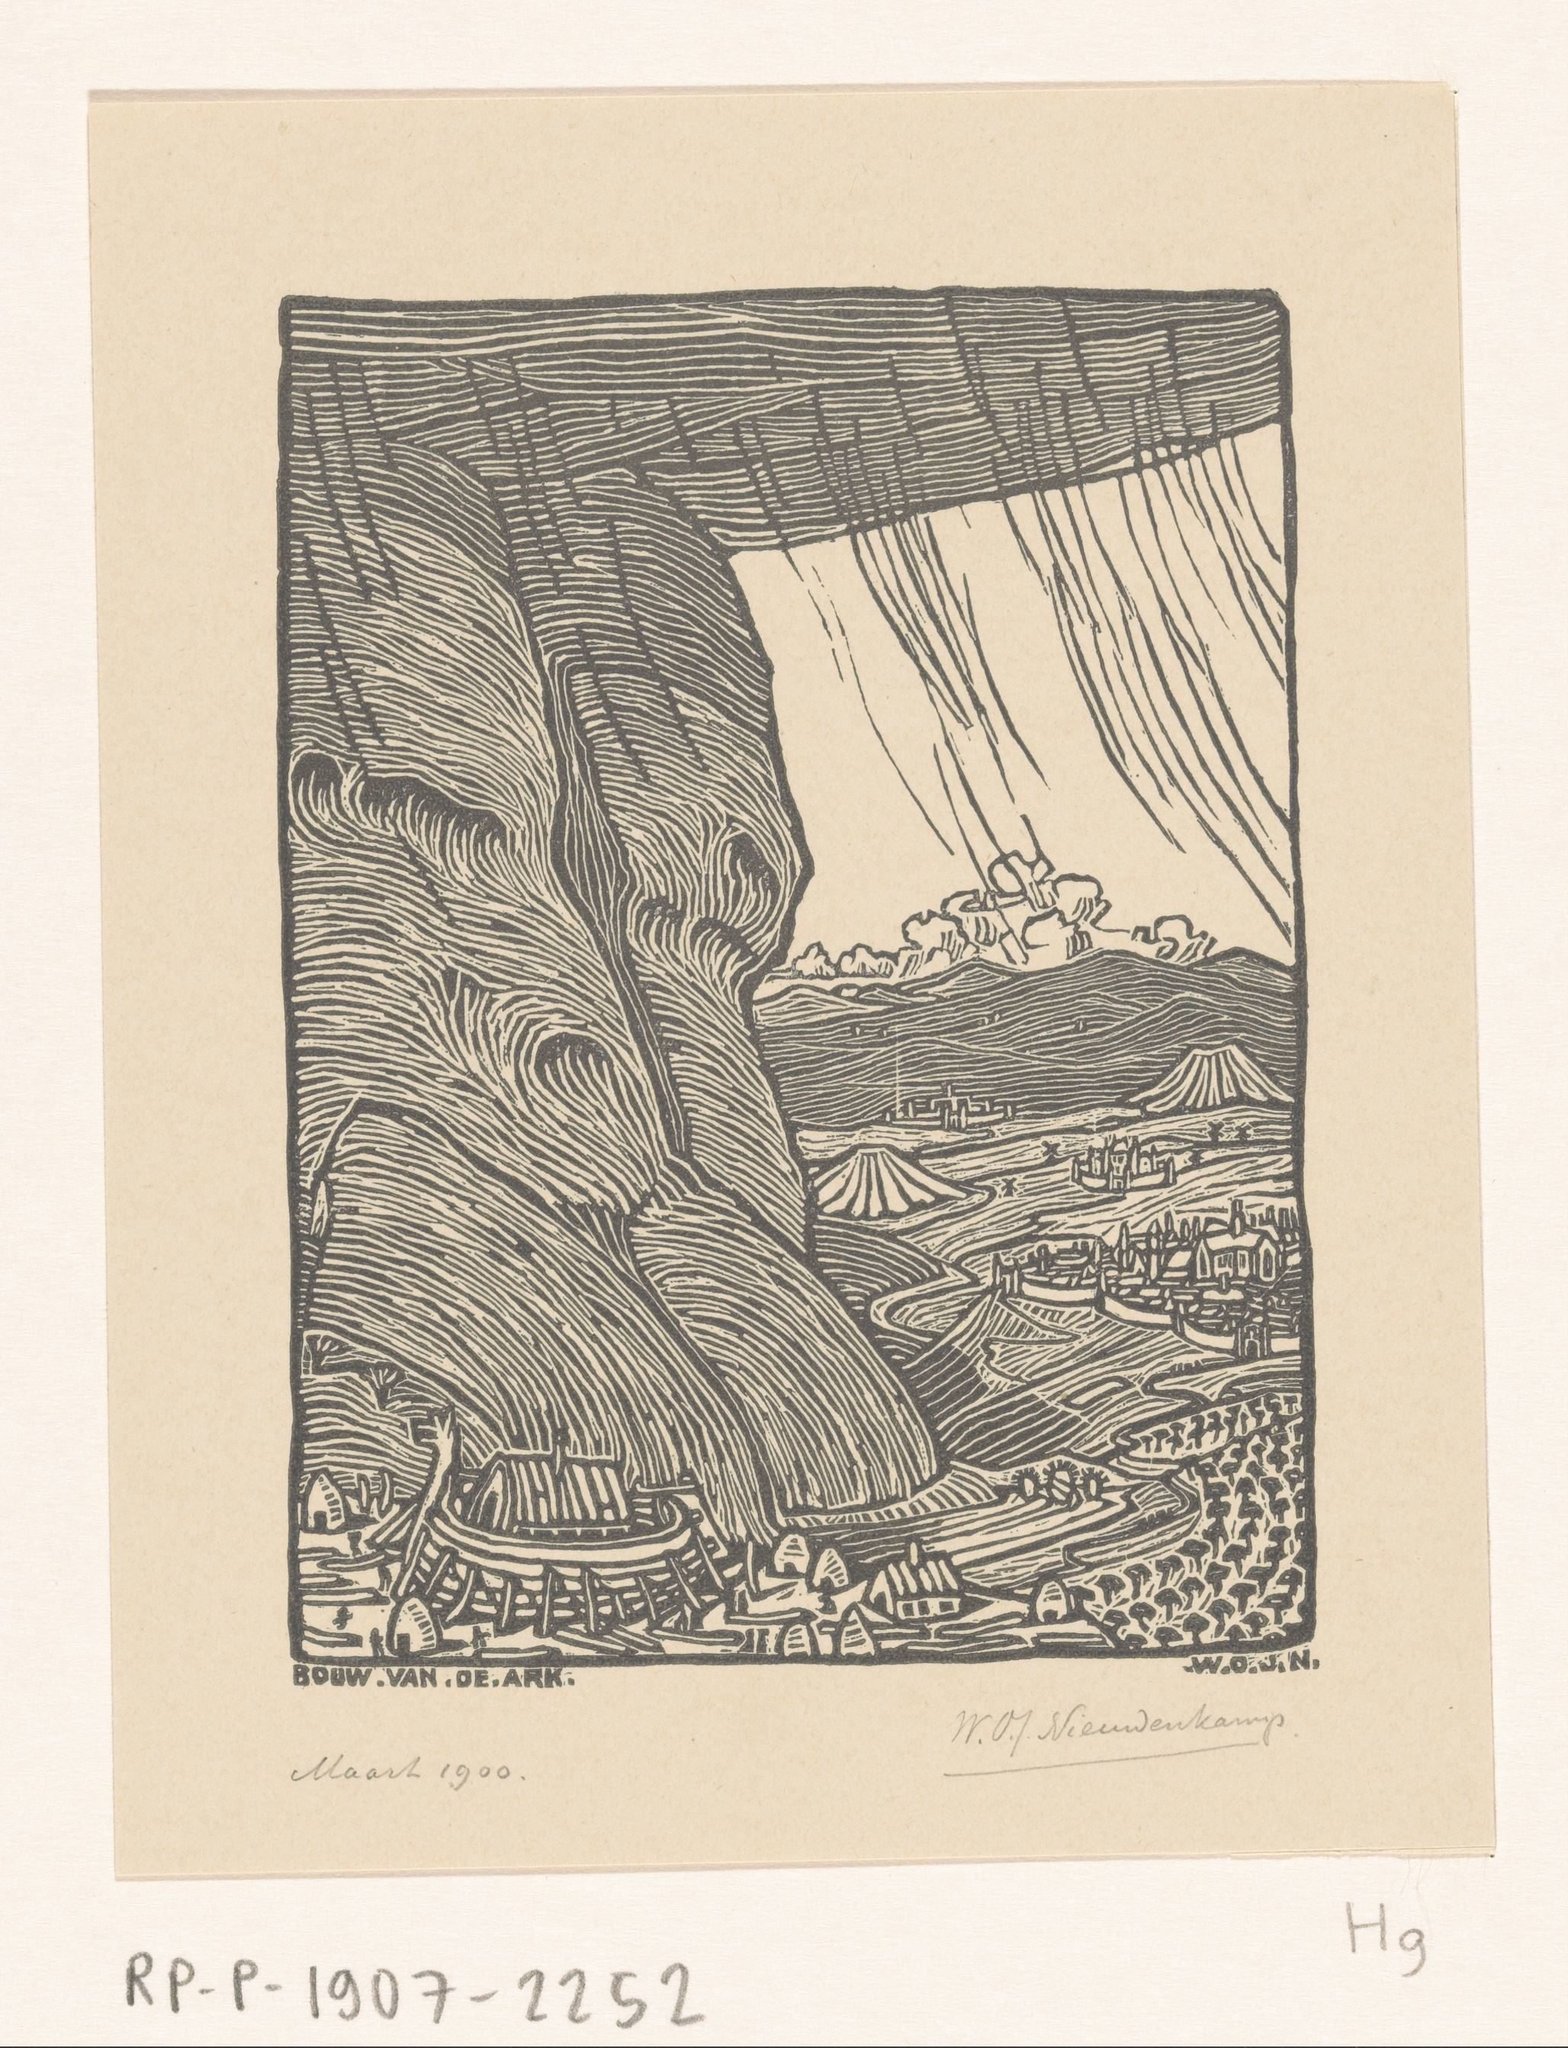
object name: print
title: Bouw van de ark van Noach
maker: wijnand otto jan nieuwenkamp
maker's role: draughtsman, print maker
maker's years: 1874-1950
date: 1900-1903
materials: paper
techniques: woodcut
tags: downpour, rain shower, the building of the ark, and the embarkation (genesis 7:5-9), mountains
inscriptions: collector's mark: Lugt 2228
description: Op de voorgrond de bijna voltooide ark, met daaromheen huizen. Links een steil gebergte, rechts een vergezicht over een vlakte met steden en boomgaarden. Uit wolken valt regen.